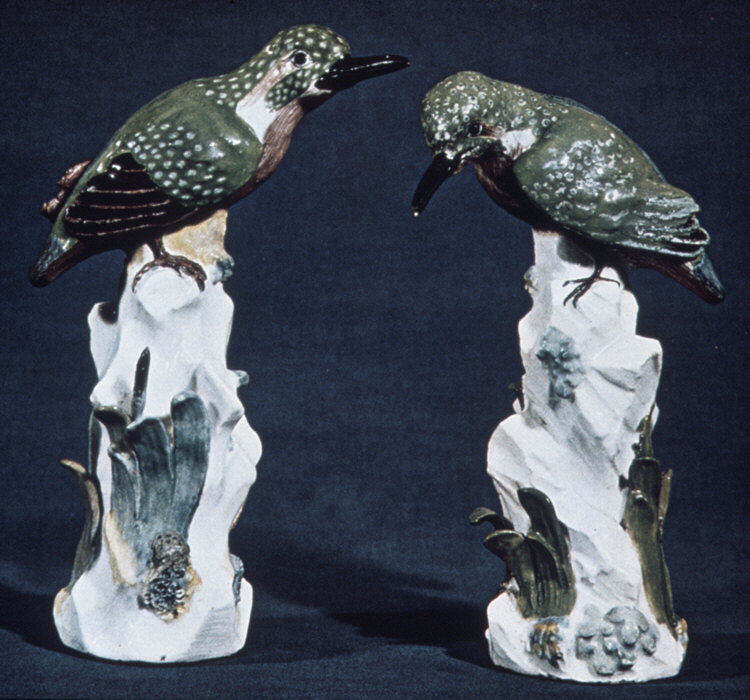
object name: figure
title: Kingfisher (one of a pair)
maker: meissen manufactory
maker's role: manufactory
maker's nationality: german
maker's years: 1710-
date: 1739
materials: hard paste porcelain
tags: birds